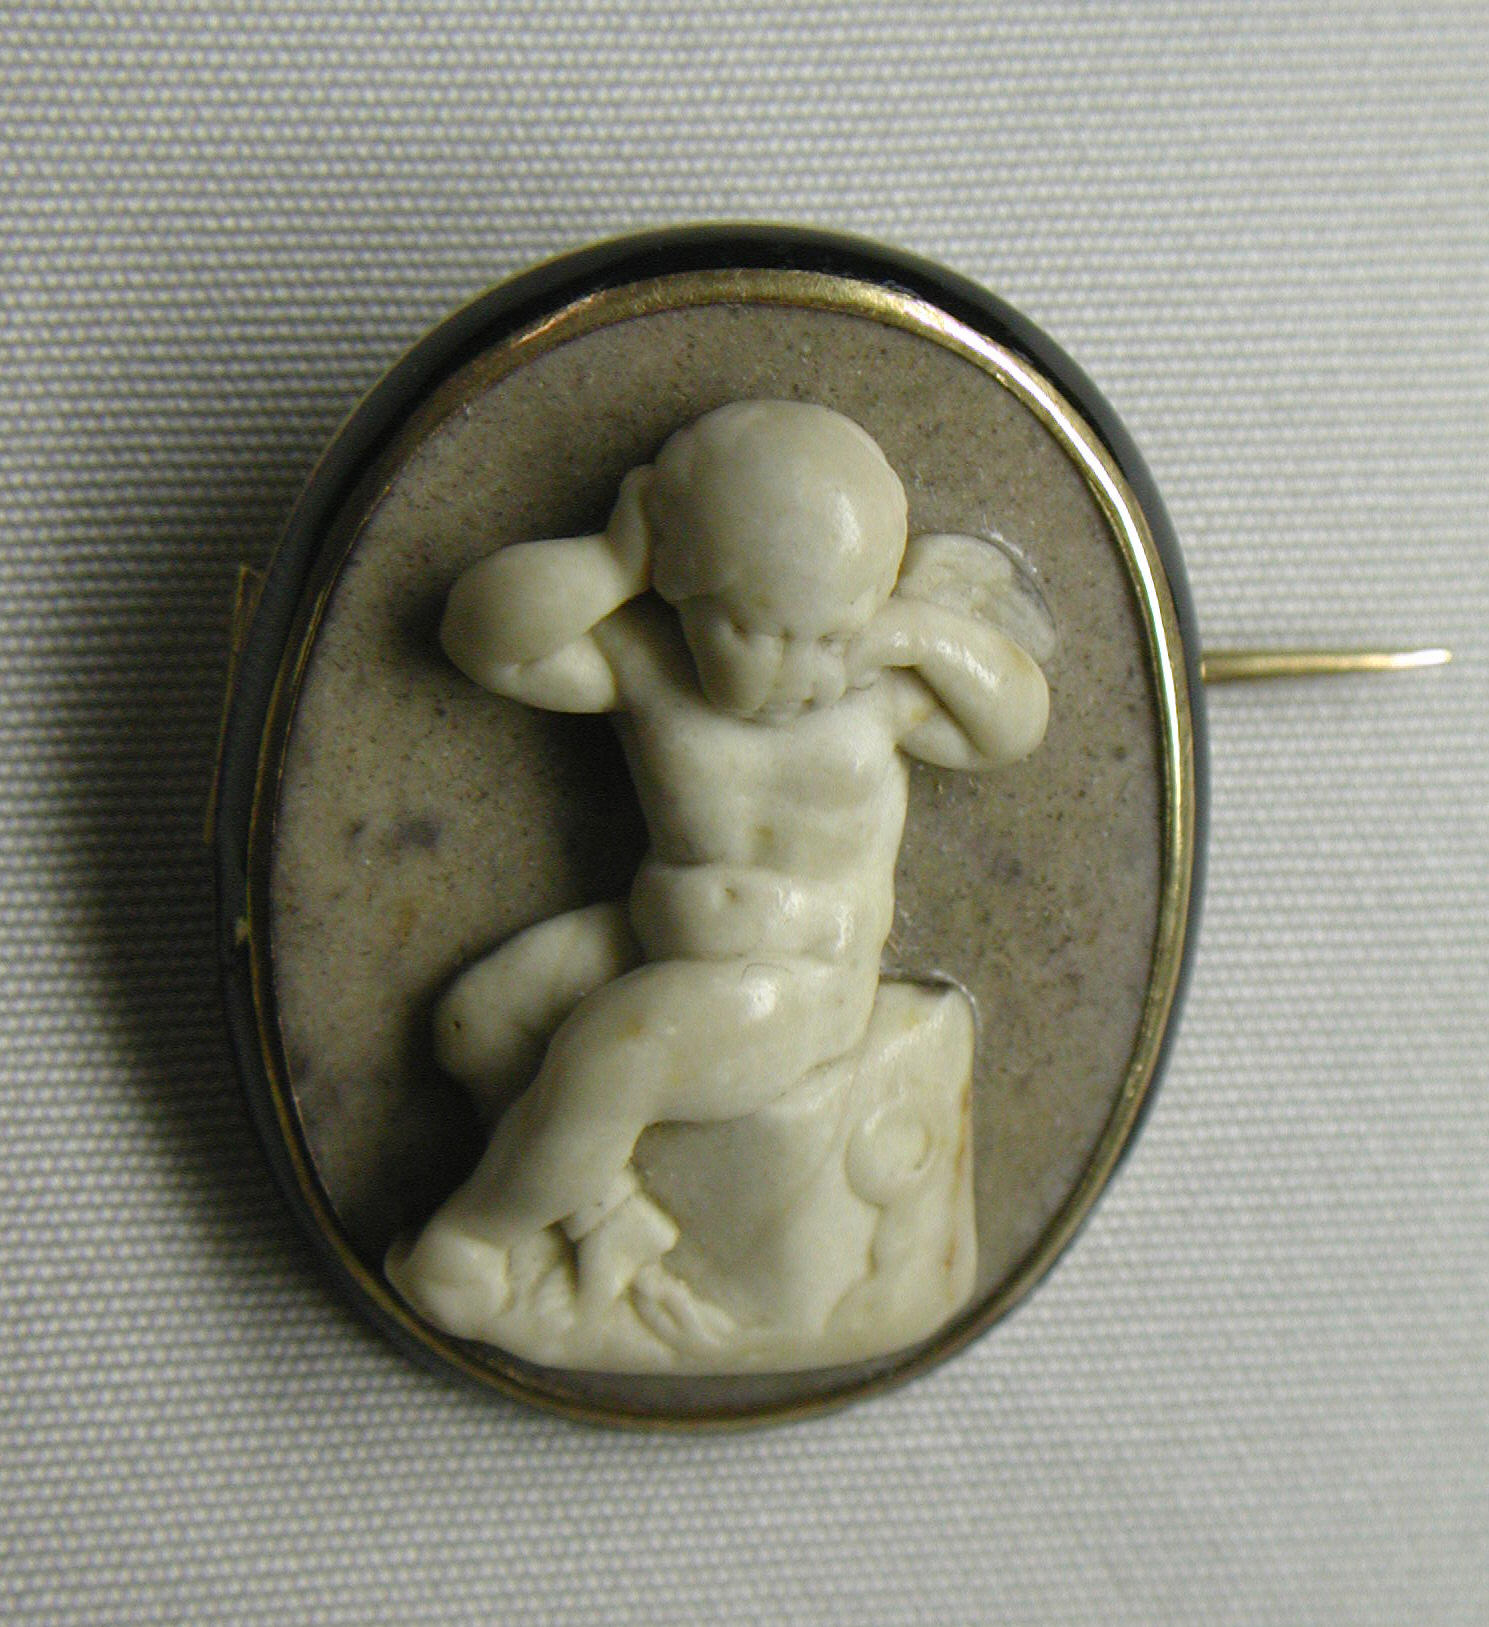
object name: cameo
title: Cupid chained to a rock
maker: giovanni pichler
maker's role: maker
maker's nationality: italian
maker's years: 1734-1791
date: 1767-1800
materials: gold, onyx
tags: cupid